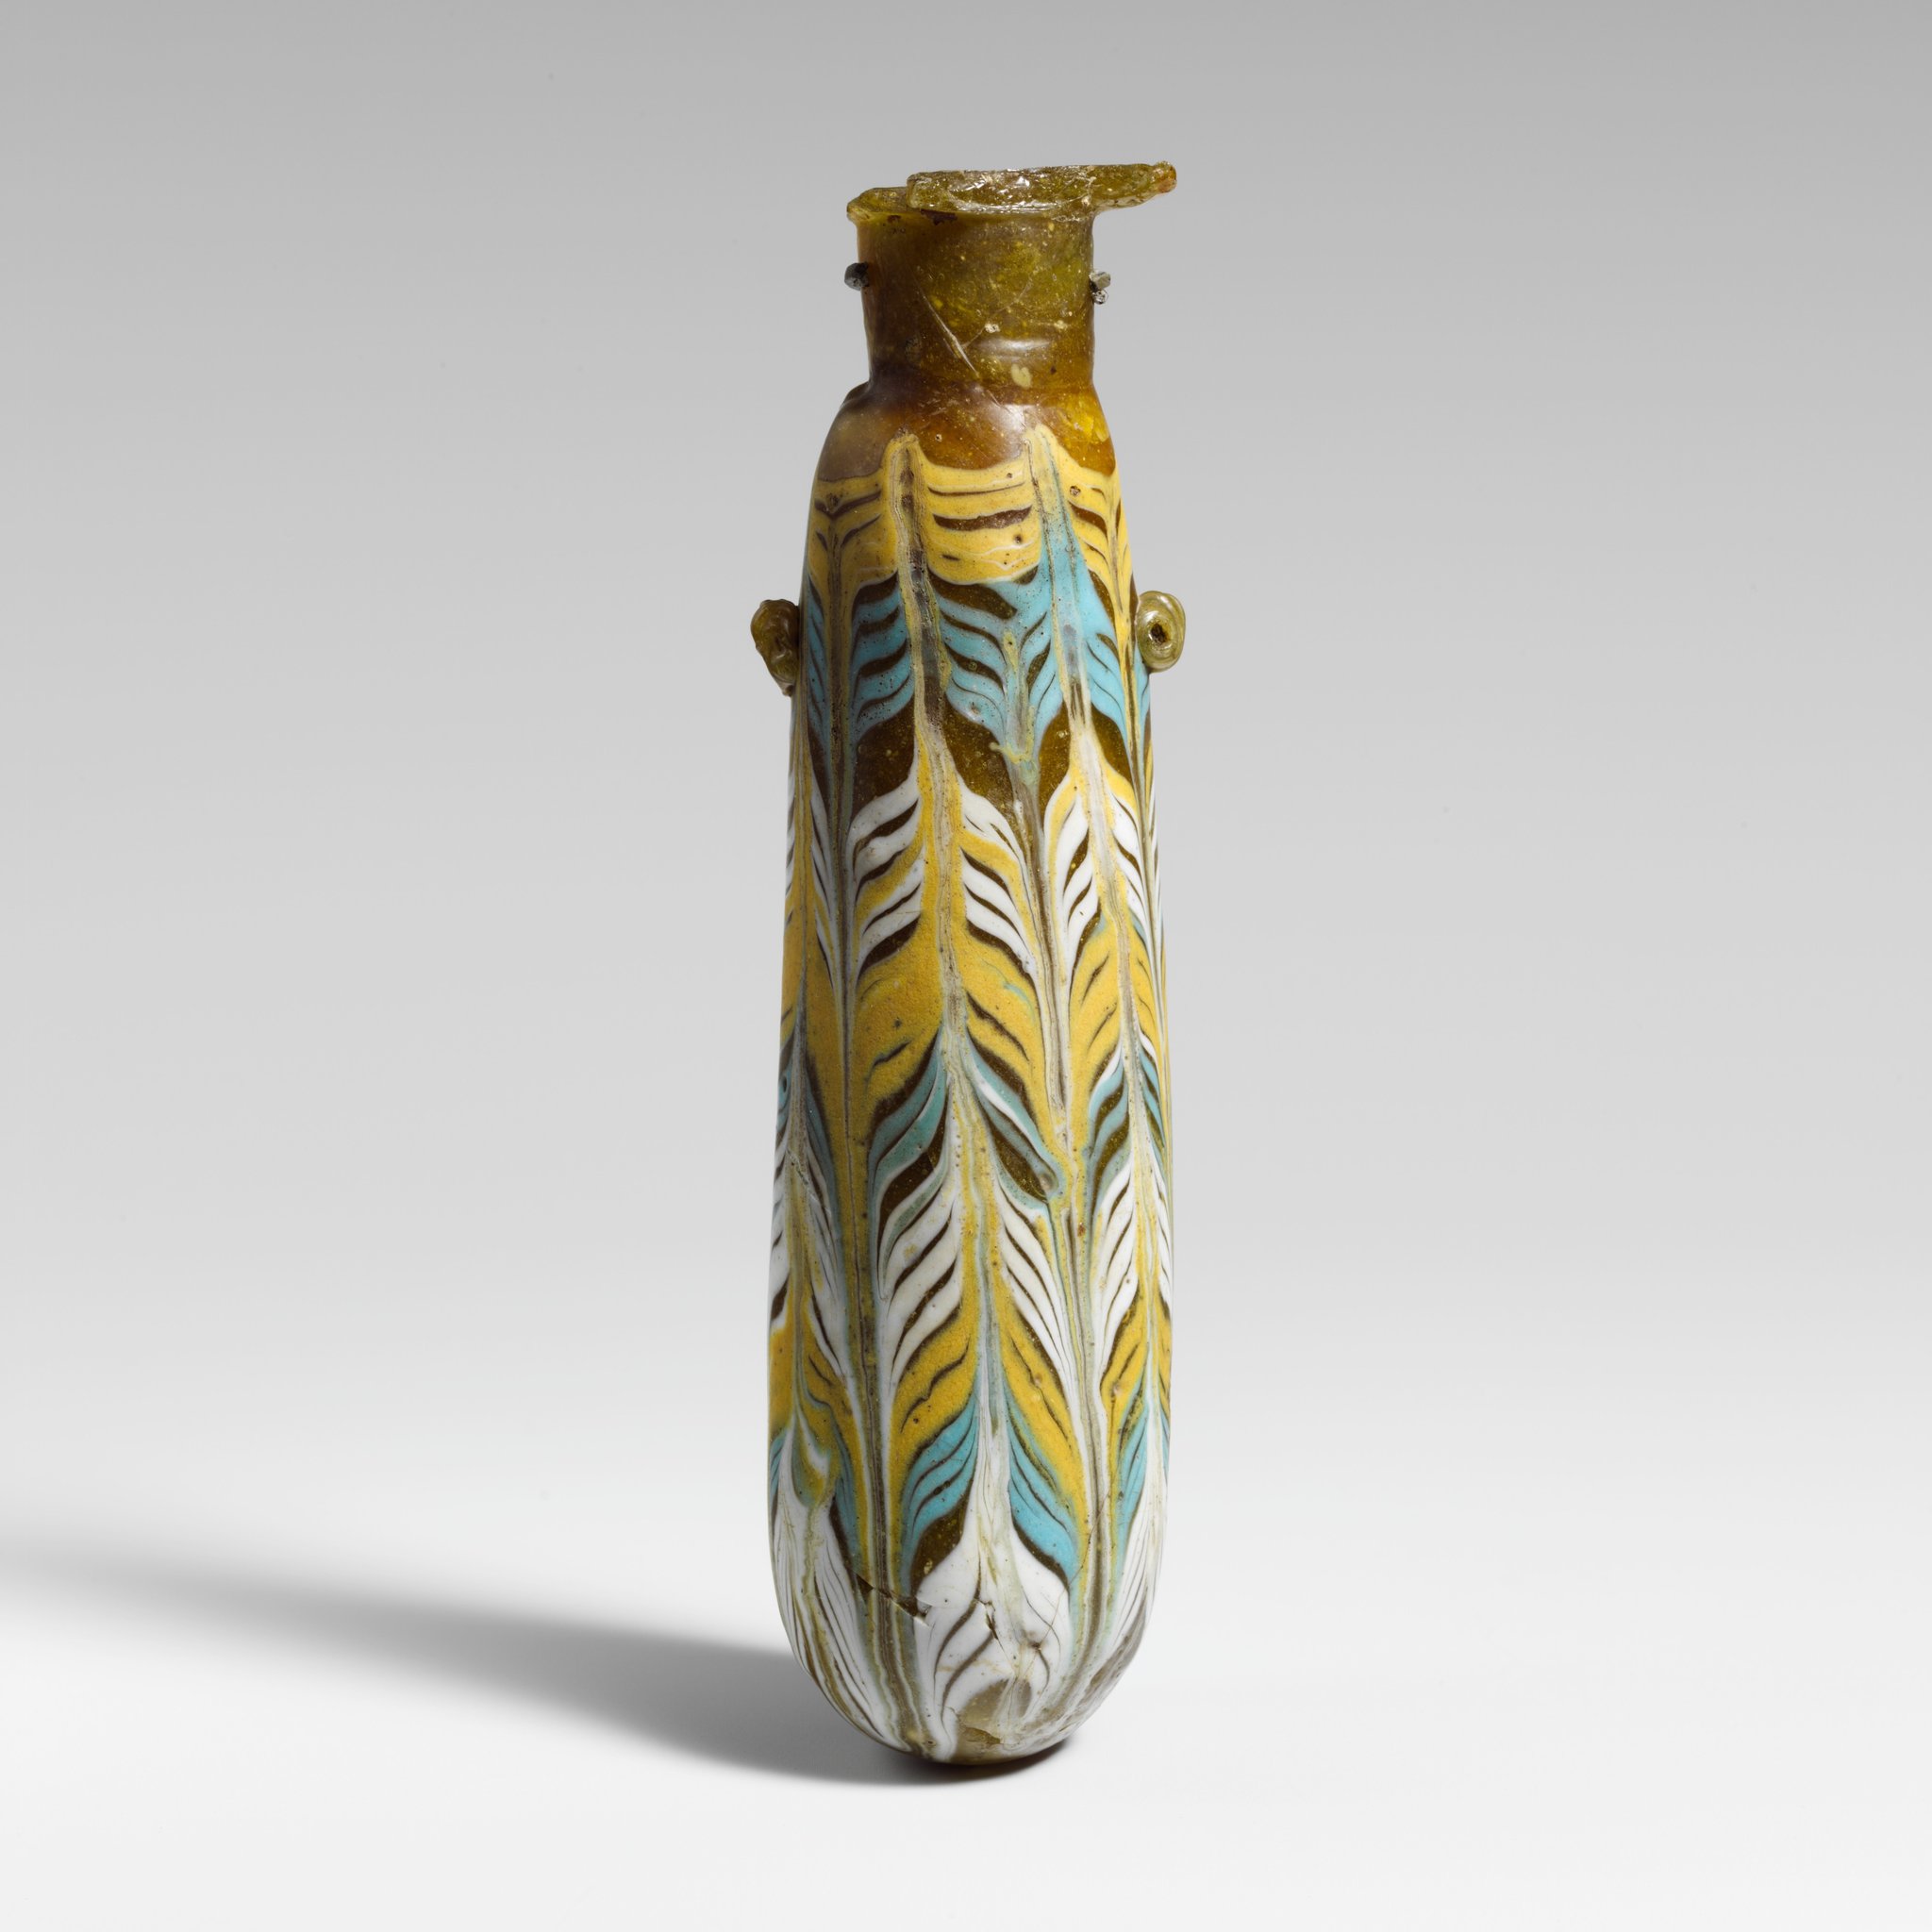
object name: alabastron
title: Glass alabastron (perfume bottle)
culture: greek, eastern mediterranean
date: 334-268 BCE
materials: glass